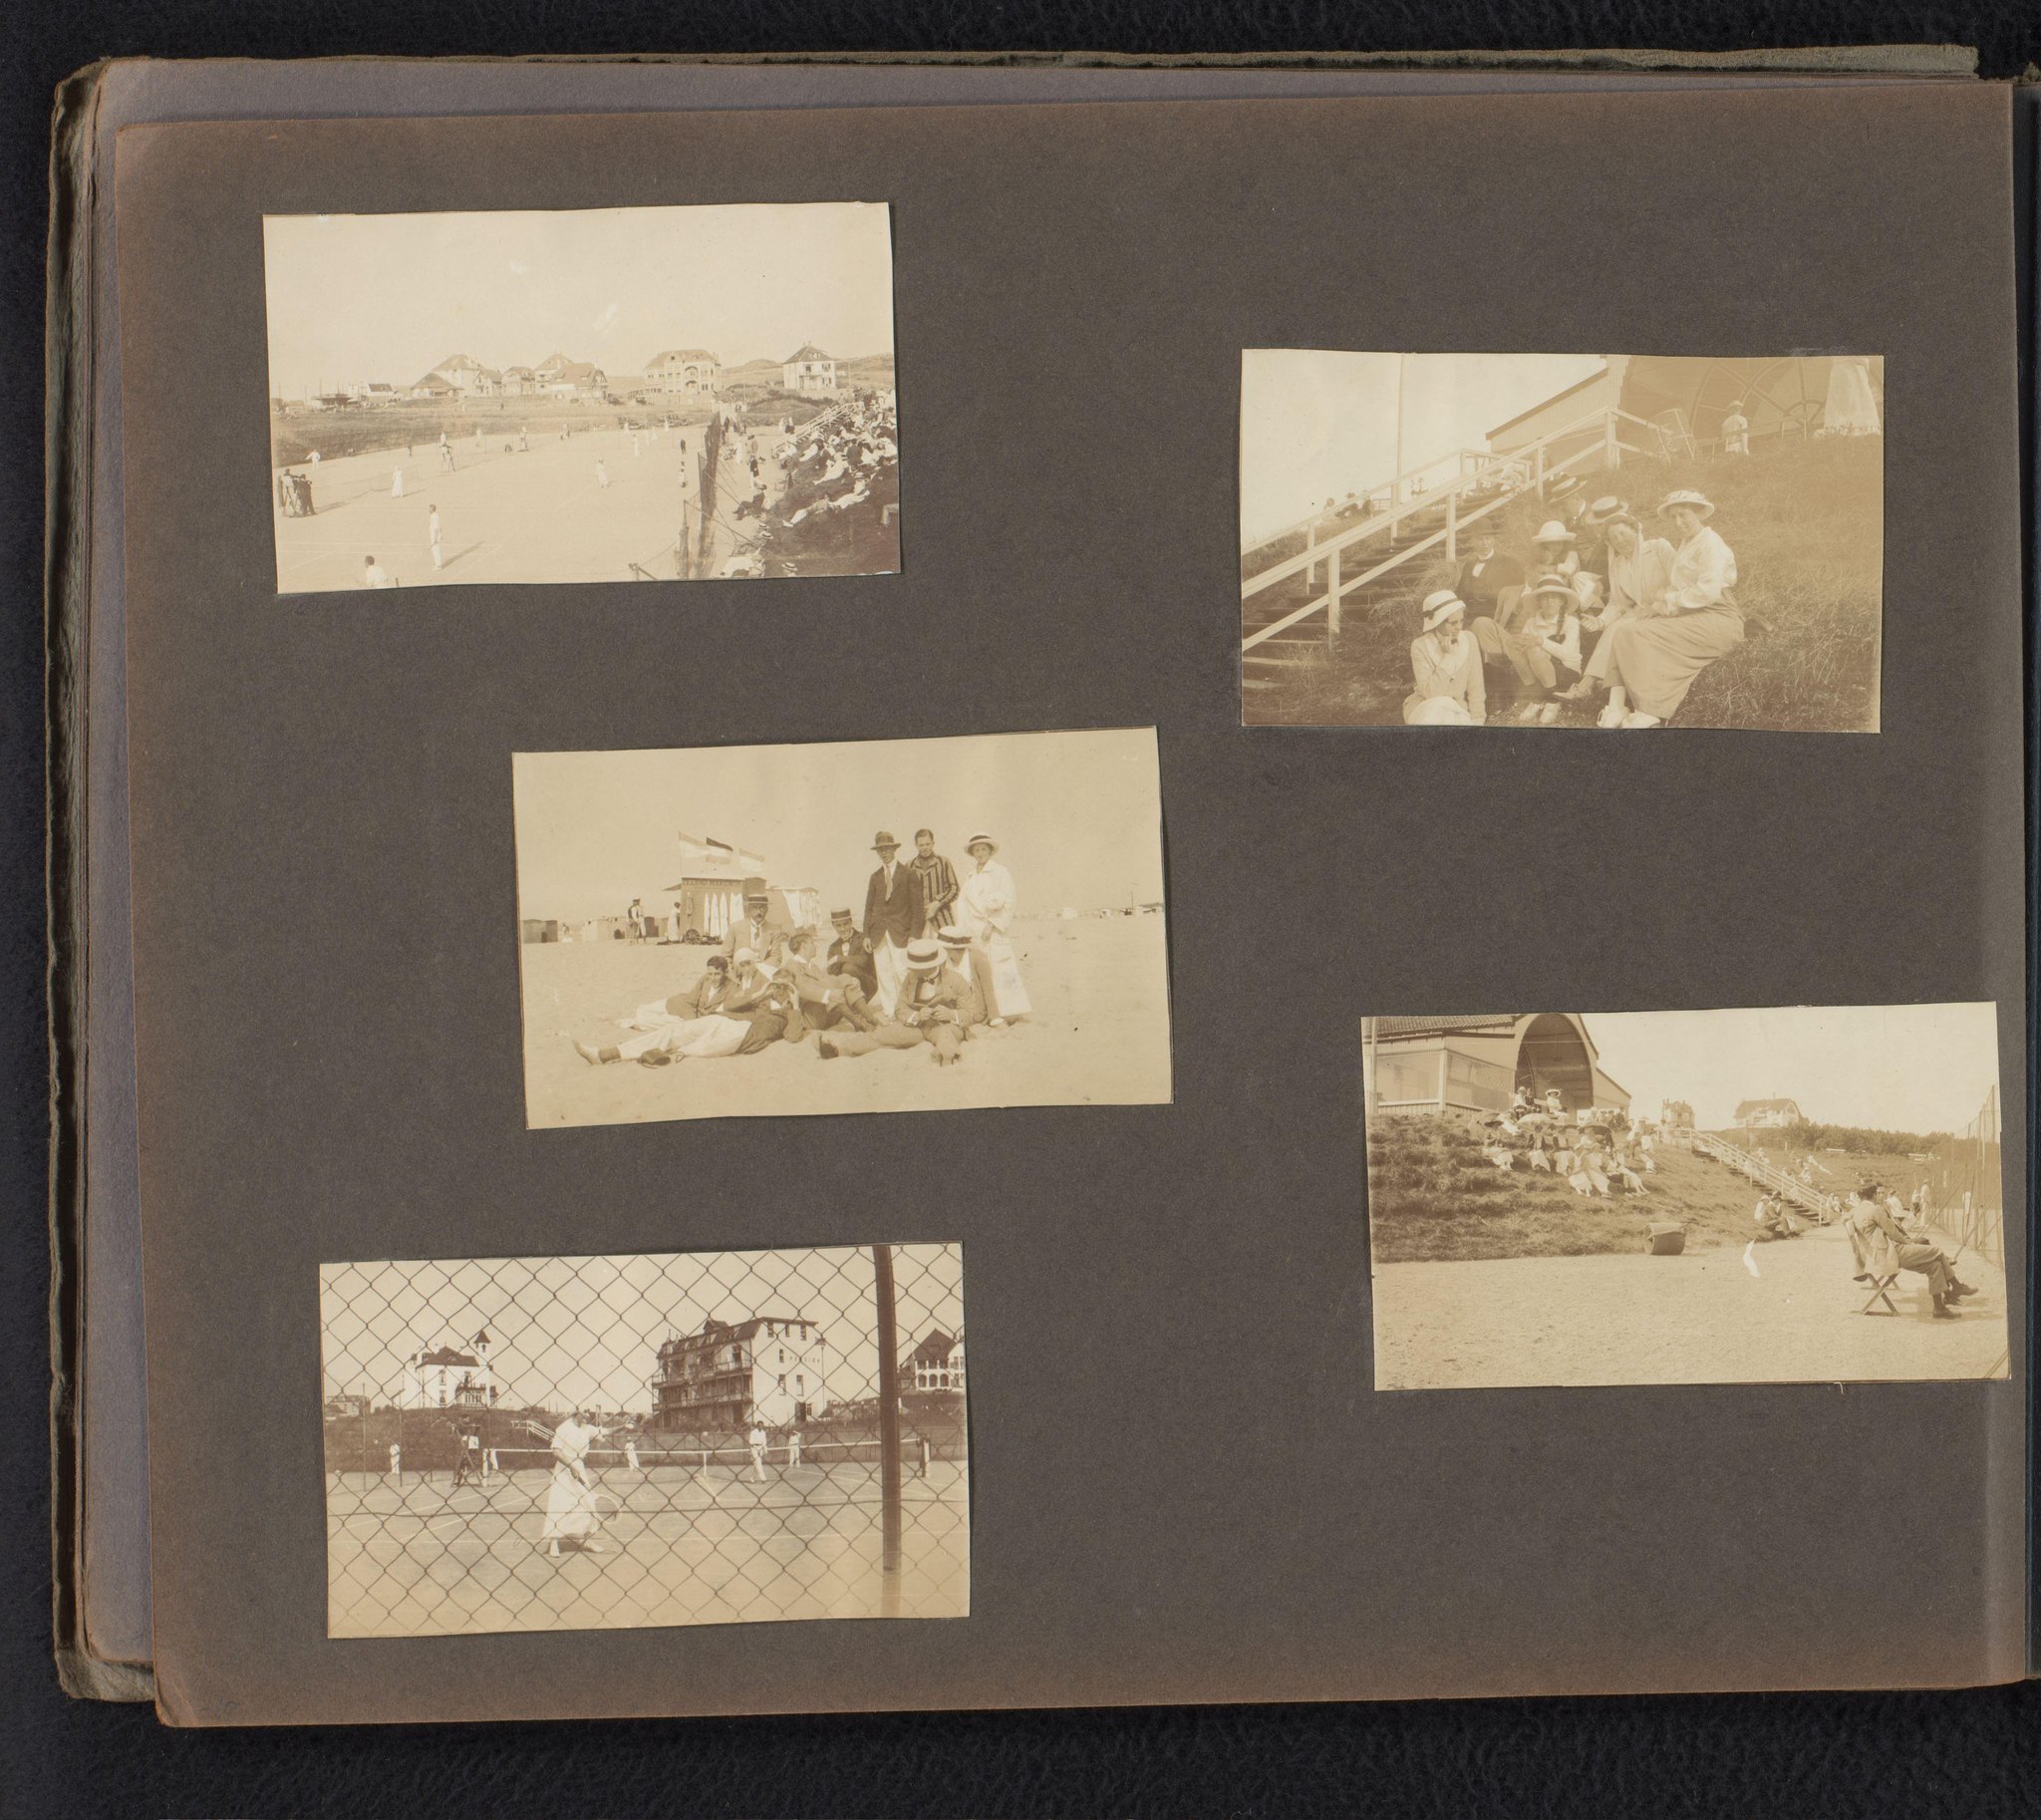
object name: album leaf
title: Vriendengroep op het strand van Noordwijk en op een tennisbaan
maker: Anonymous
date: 1913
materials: paper, cardboard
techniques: gelatin silver print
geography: noordwijk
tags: beach (as place of recreation), tennis, lawn-tennis, anonymous historical person portrayed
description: Deze foto's zijn onderdeel van een album.